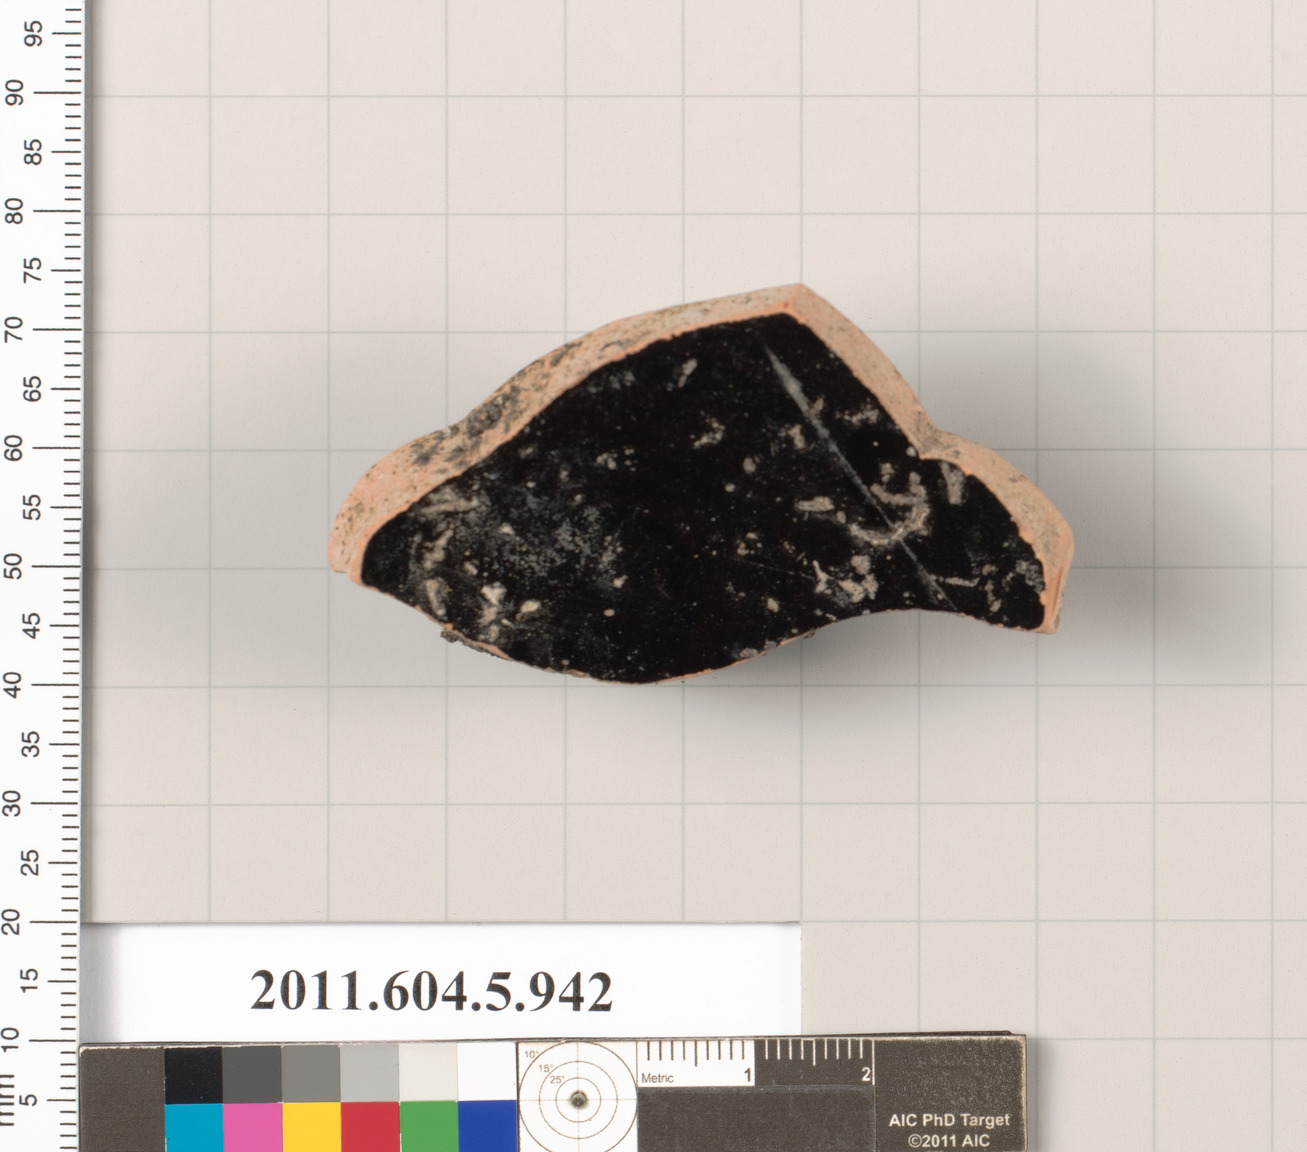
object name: kylix fragment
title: Terracotta fragment of a kylix (drinking cup)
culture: greek, attic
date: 600-401 BCE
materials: terracotta